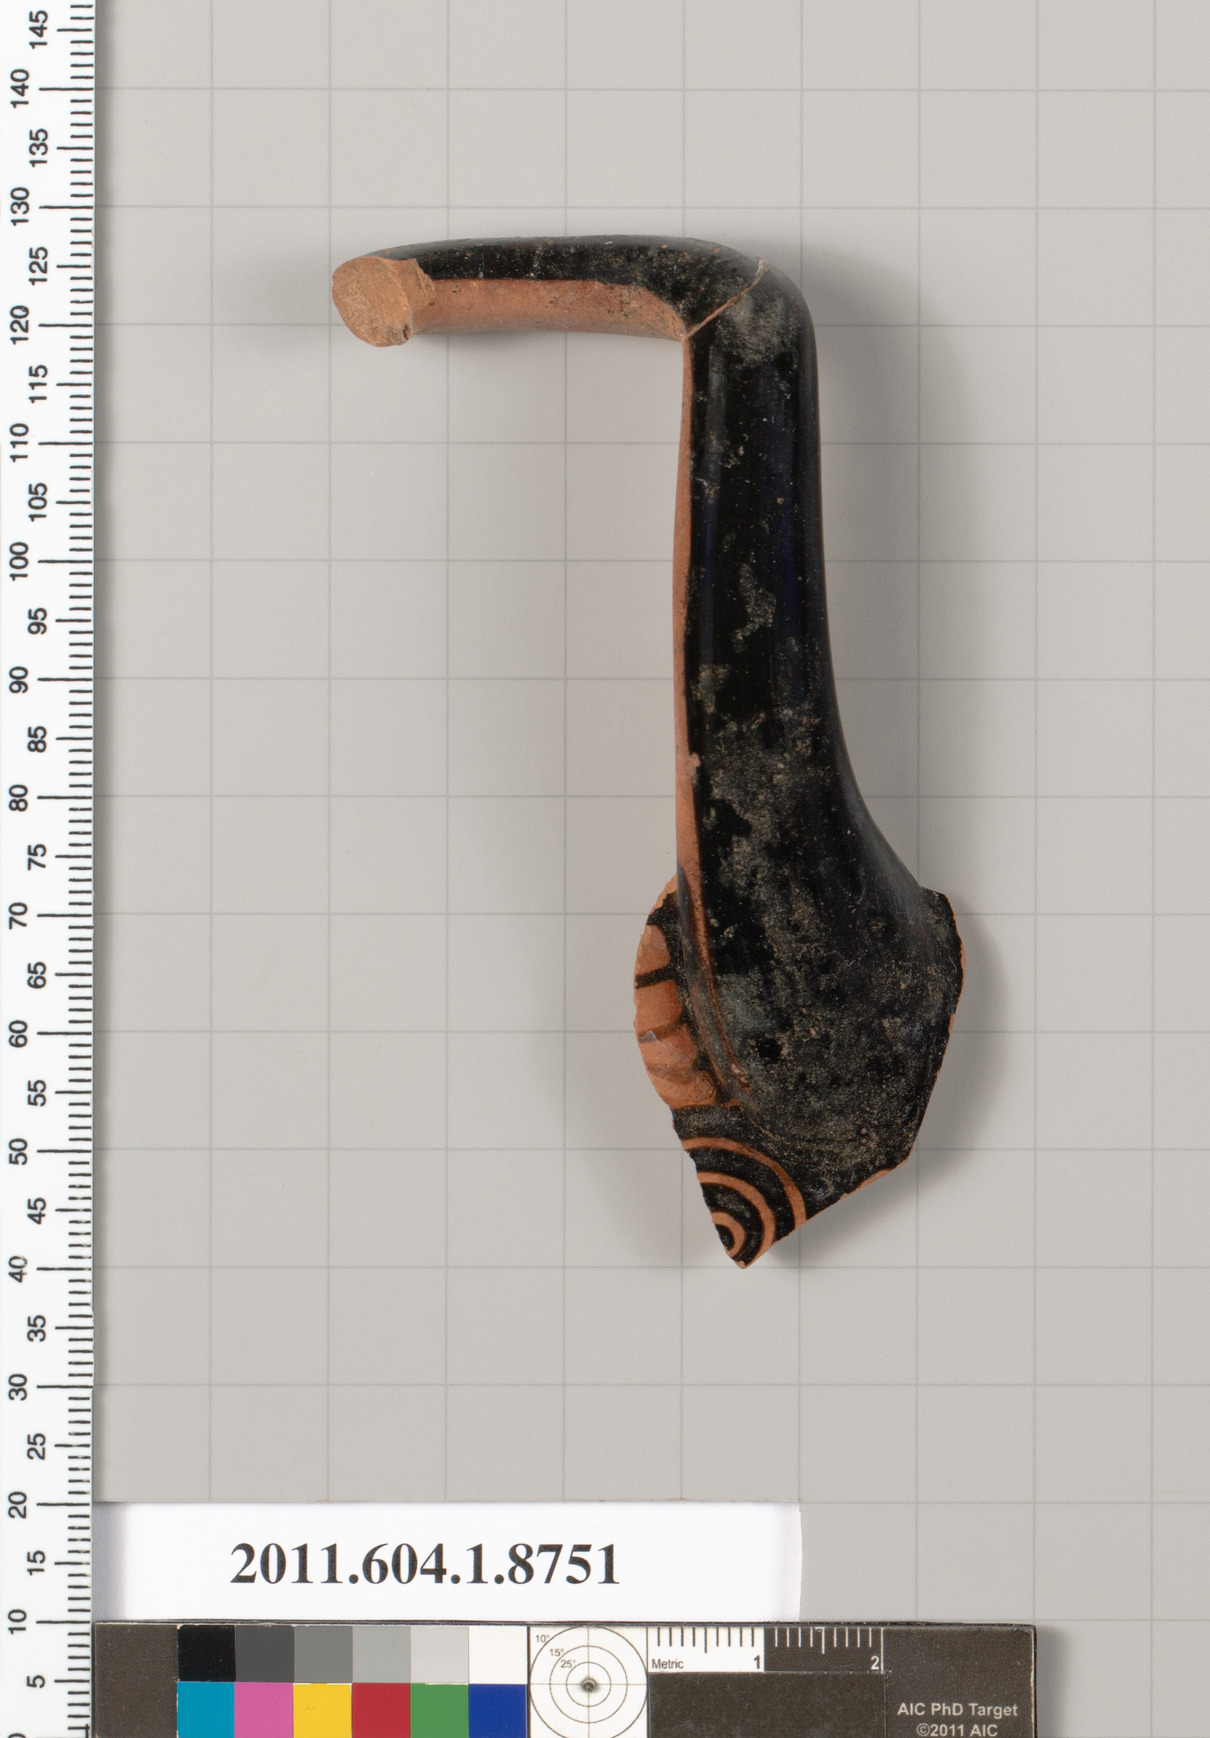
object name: kylix fragment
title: Terracotta fragment of a kylix (drinking cup)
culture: greek, attic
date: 460-450 BCE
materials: terracotta